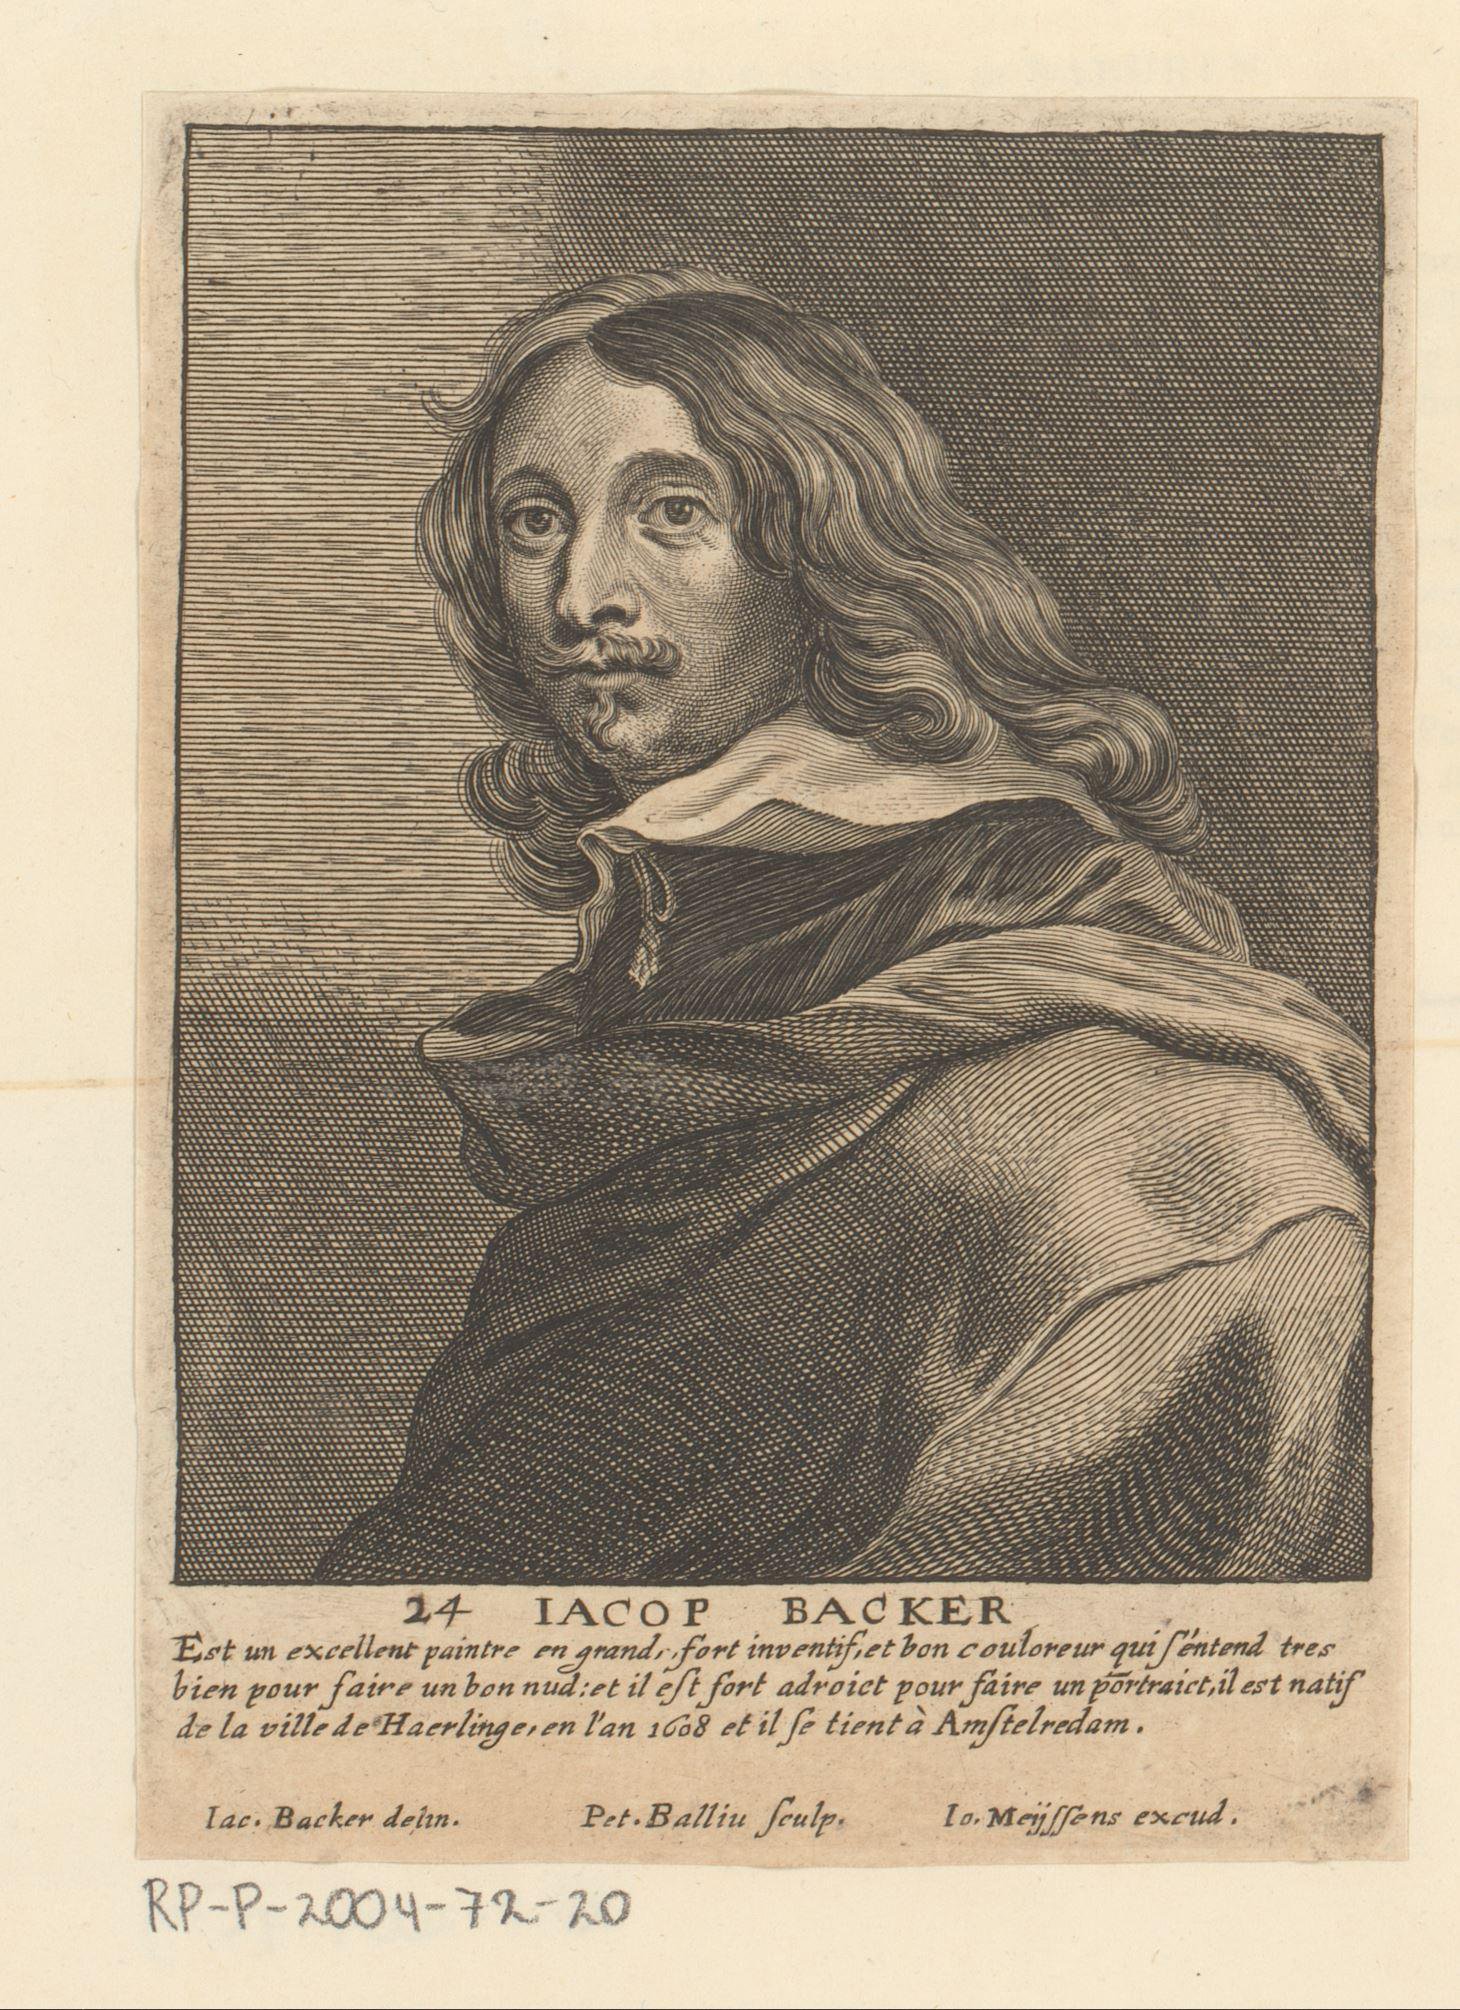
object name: print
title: Portret van Jacob Adriaensz. Backer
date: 1649-1662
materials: paper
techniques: engraving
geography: antwerp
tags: harlingen, amsterdam, painter, draughtsman, jacob adriaensz backer, historical persons, portrait, self-portrait of painter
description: Prent mogelijk uit: Meyssens, Joannes. Image de divers hommes desprit sublime qui par leur art et science deburovent vivre eternellement et des quels la louange et renommée faict estonner le monde. Antwerpen: Joannes Meyssens, 1649, dl. 1, p. 18. Andere staat van prent gebruikt in: Bie, Cornelis De. Het gulden Cabinet vande edel vry schilder const, inhoudende den lof vande vermarste schilders, architecte, beldthowers ende plaetsnyders van dese eeuw. Antwerpen: Joannes Meyssens, 1662 [1661 foutief op titelpagina], p. 129. De samensteller heeft deze prent in het album geplakt als illustratie bij: Pilkington, Matthew en Johann Heinrich Füssli. A dictionary of painters, from the revival of the art to the present period. 4 dln. Londen: John Crowder, 1805, dl. 1, p. 21.